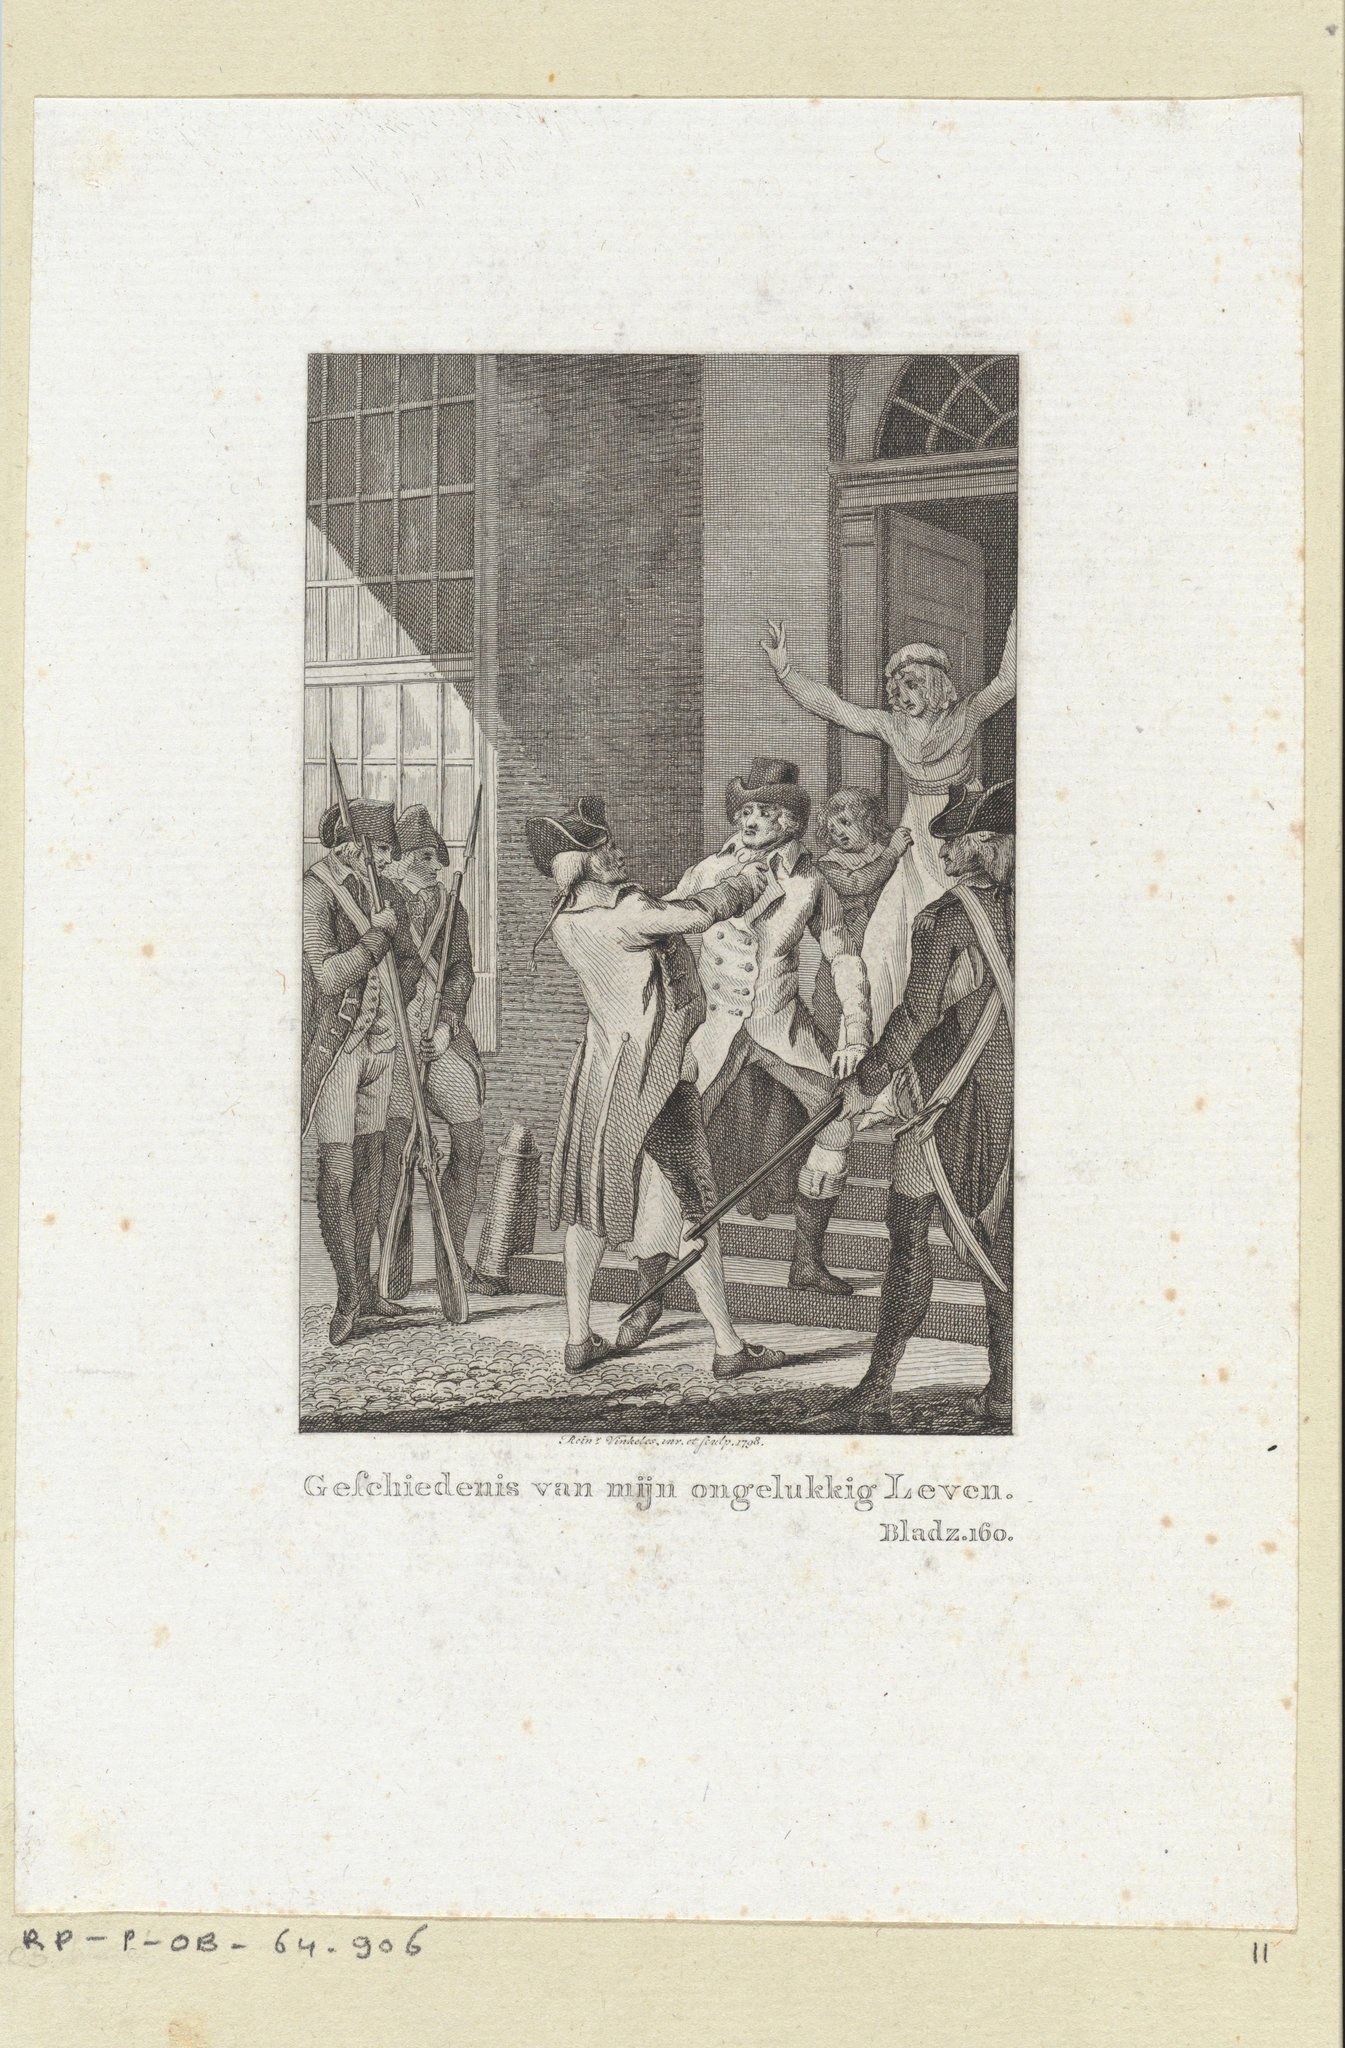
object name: print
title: Geschil tussen twee mannen voor een huis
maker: reinier vinkeles (i)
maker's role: draughtsman, print maker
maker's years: 1741-1816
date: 1798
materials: paper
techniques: engraving, etching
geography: amsterdam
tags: soldiers and civilians, family, descendance, quarrel, argument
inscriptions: inscription: ‘Geschiedenis van mijn ongelukkig Leven. / Bladz. 160.’, collector's mark: Lugt 2228